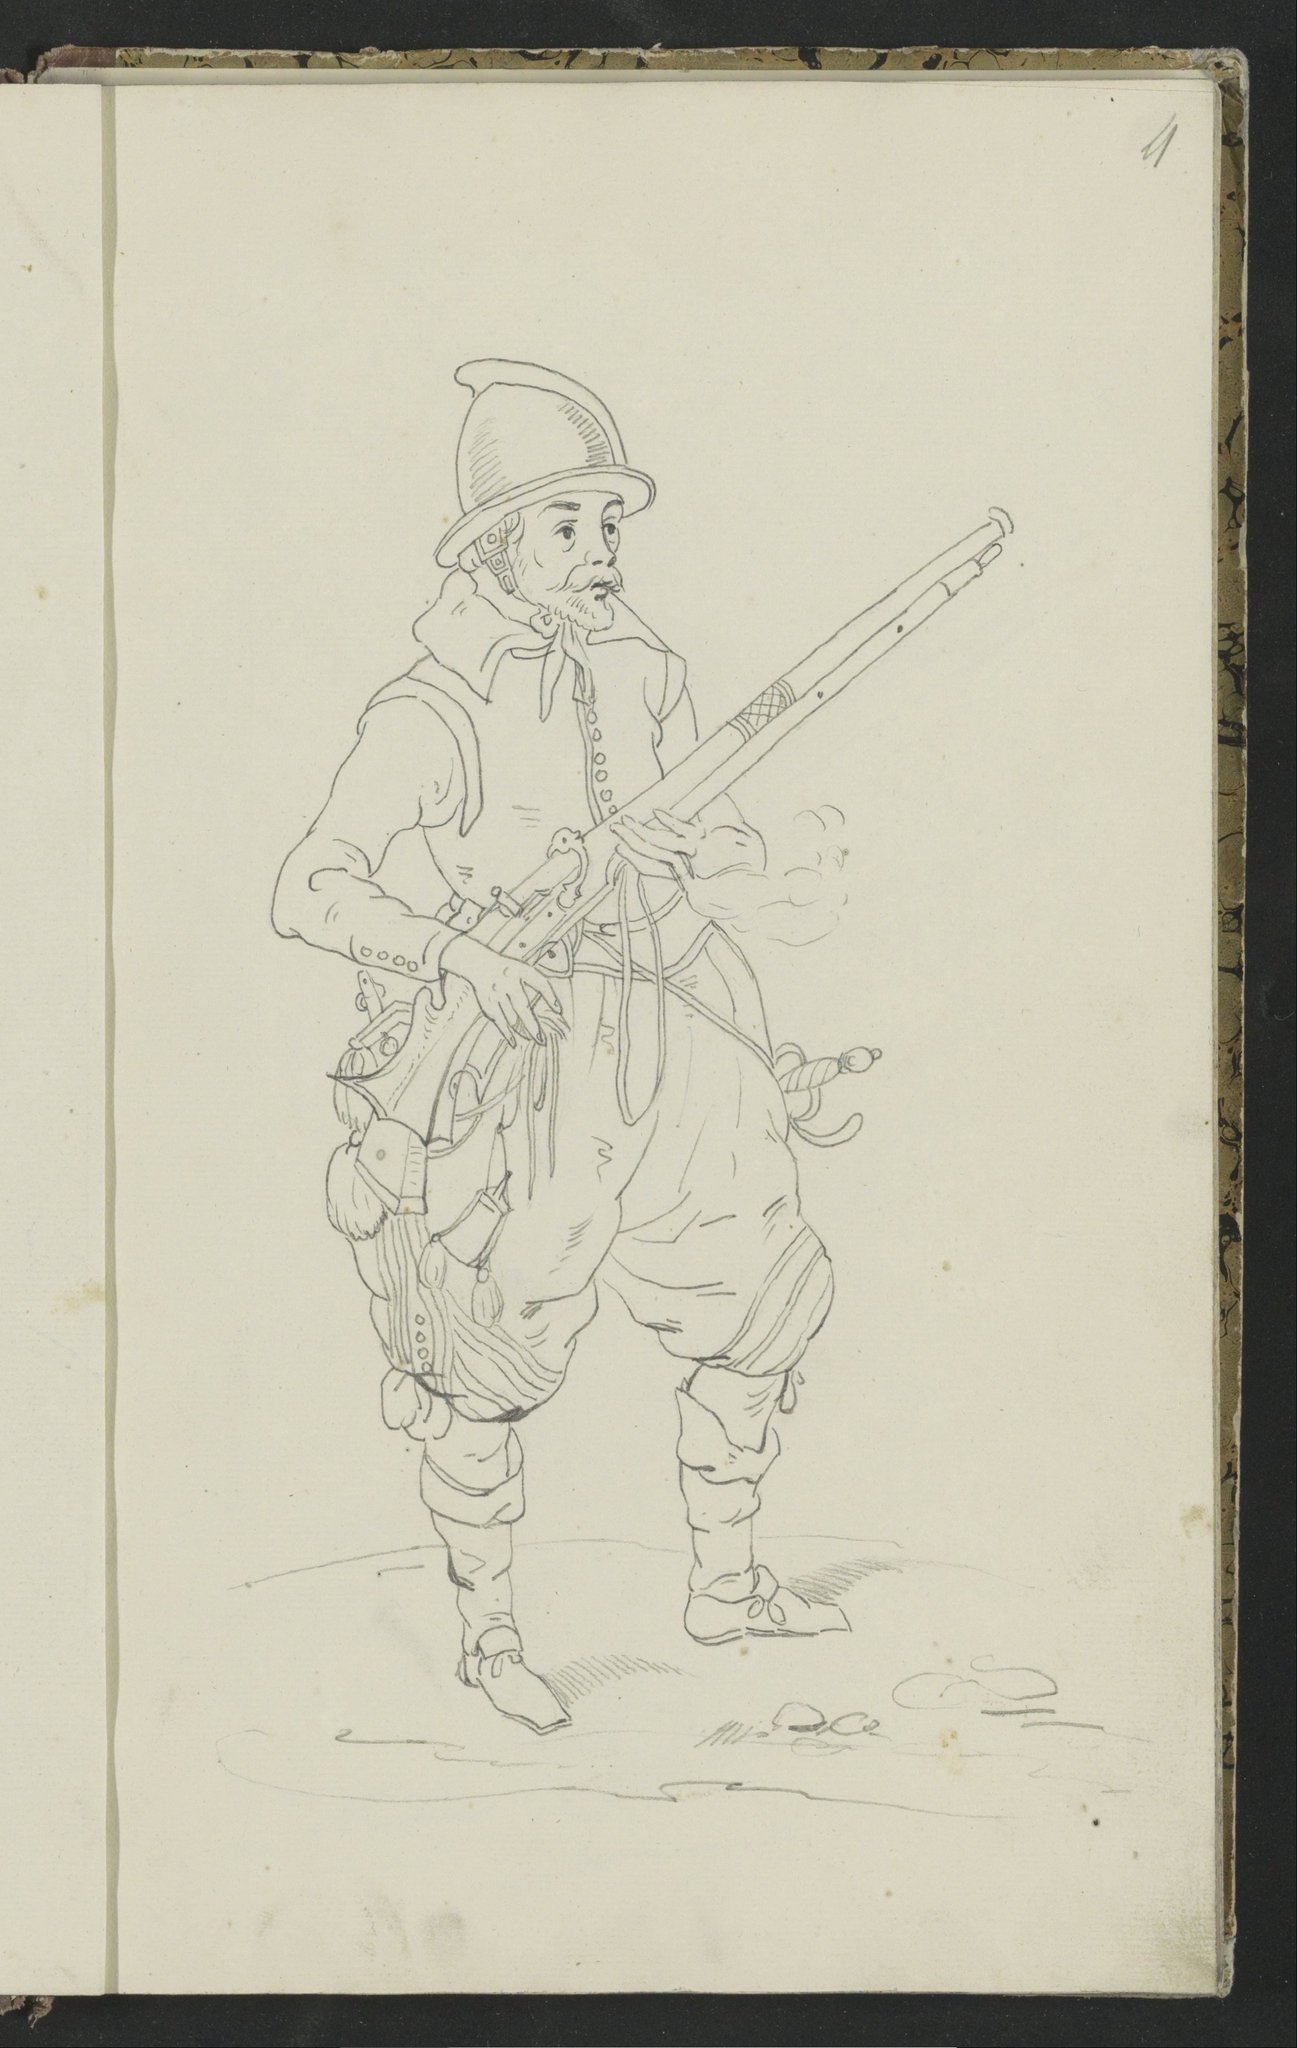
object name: sketchbook leaf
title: Soldaat die zijn musket in beiden handen draagt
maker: johannes antonius canta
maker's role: draughtsman, painter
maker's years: 1816-1888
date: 1826-1888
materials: paper, pencil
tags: firearms, (military) uniforms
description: Kopie naar Jacob de Gheyns 'Wapenhandelinghe van roers musquetten ende spiessen: achtervolghende de ordre van syn excellentie Maurits prince van Orangie grave van Nassau &c' uit 1607. Blad 4 recto uit een schetsboek en album met 59 bladen.